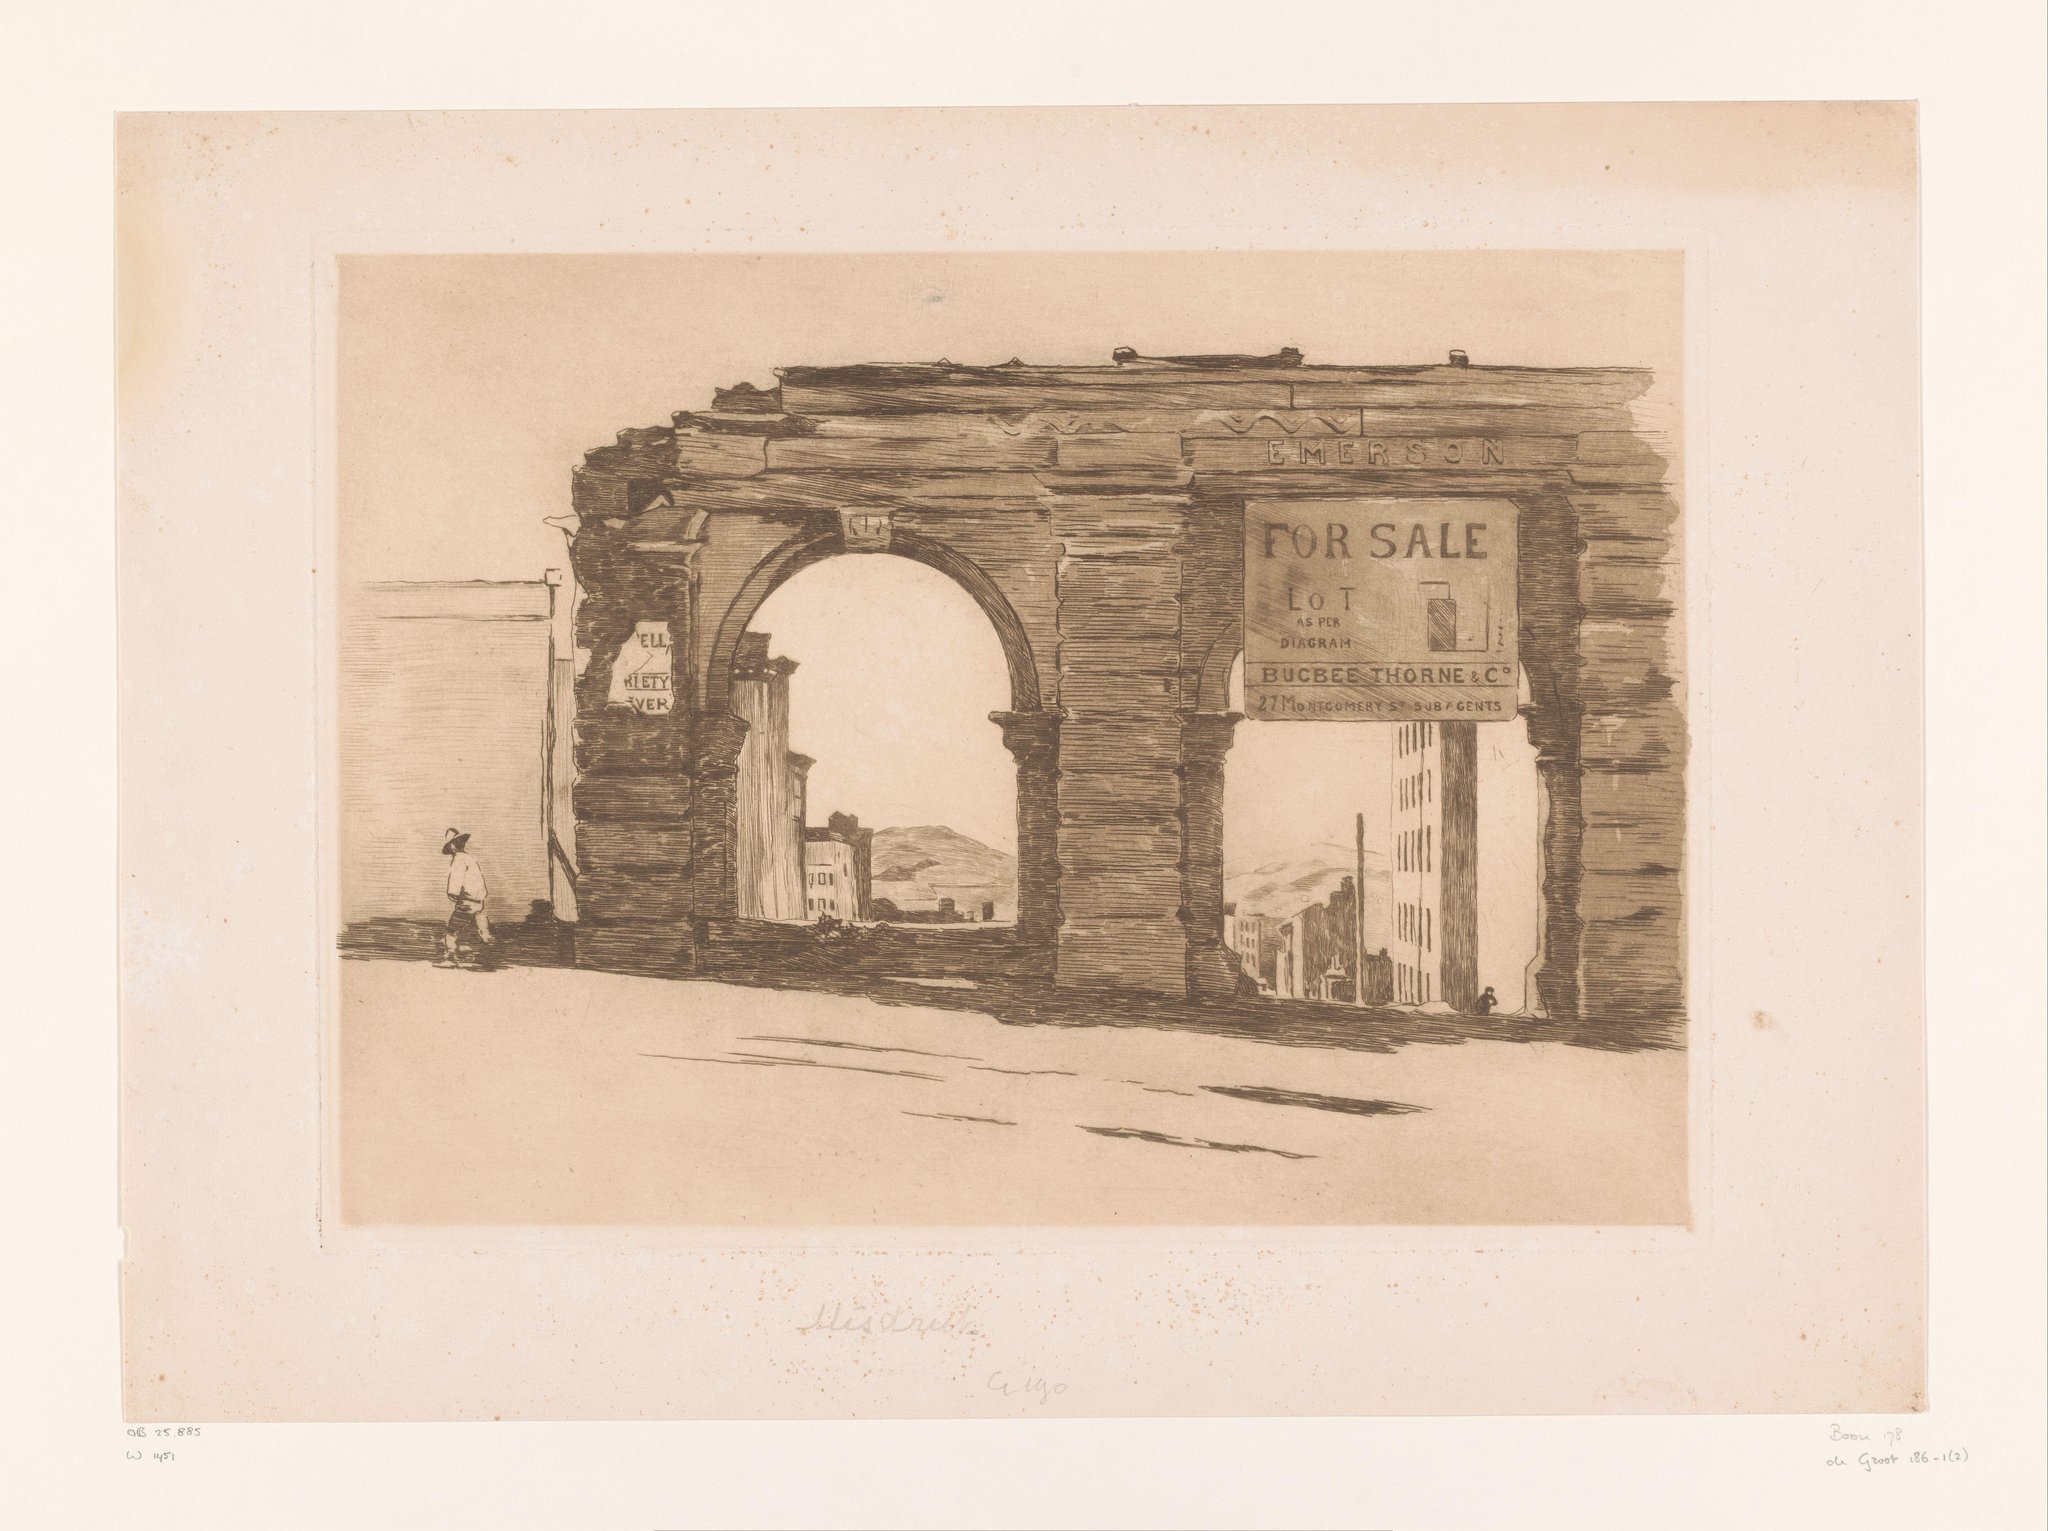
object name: print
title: Ruïne van de firma Thos. Emery Sons, San Francisco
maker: willem witsen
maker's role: draughtsman, painter, print maker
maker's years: 1860-1923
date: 1915-1919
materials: paper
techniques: aquatint, etching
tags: ruin of a building ~ architecture, collapsing building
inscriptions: annotation: ‘Misdruk’